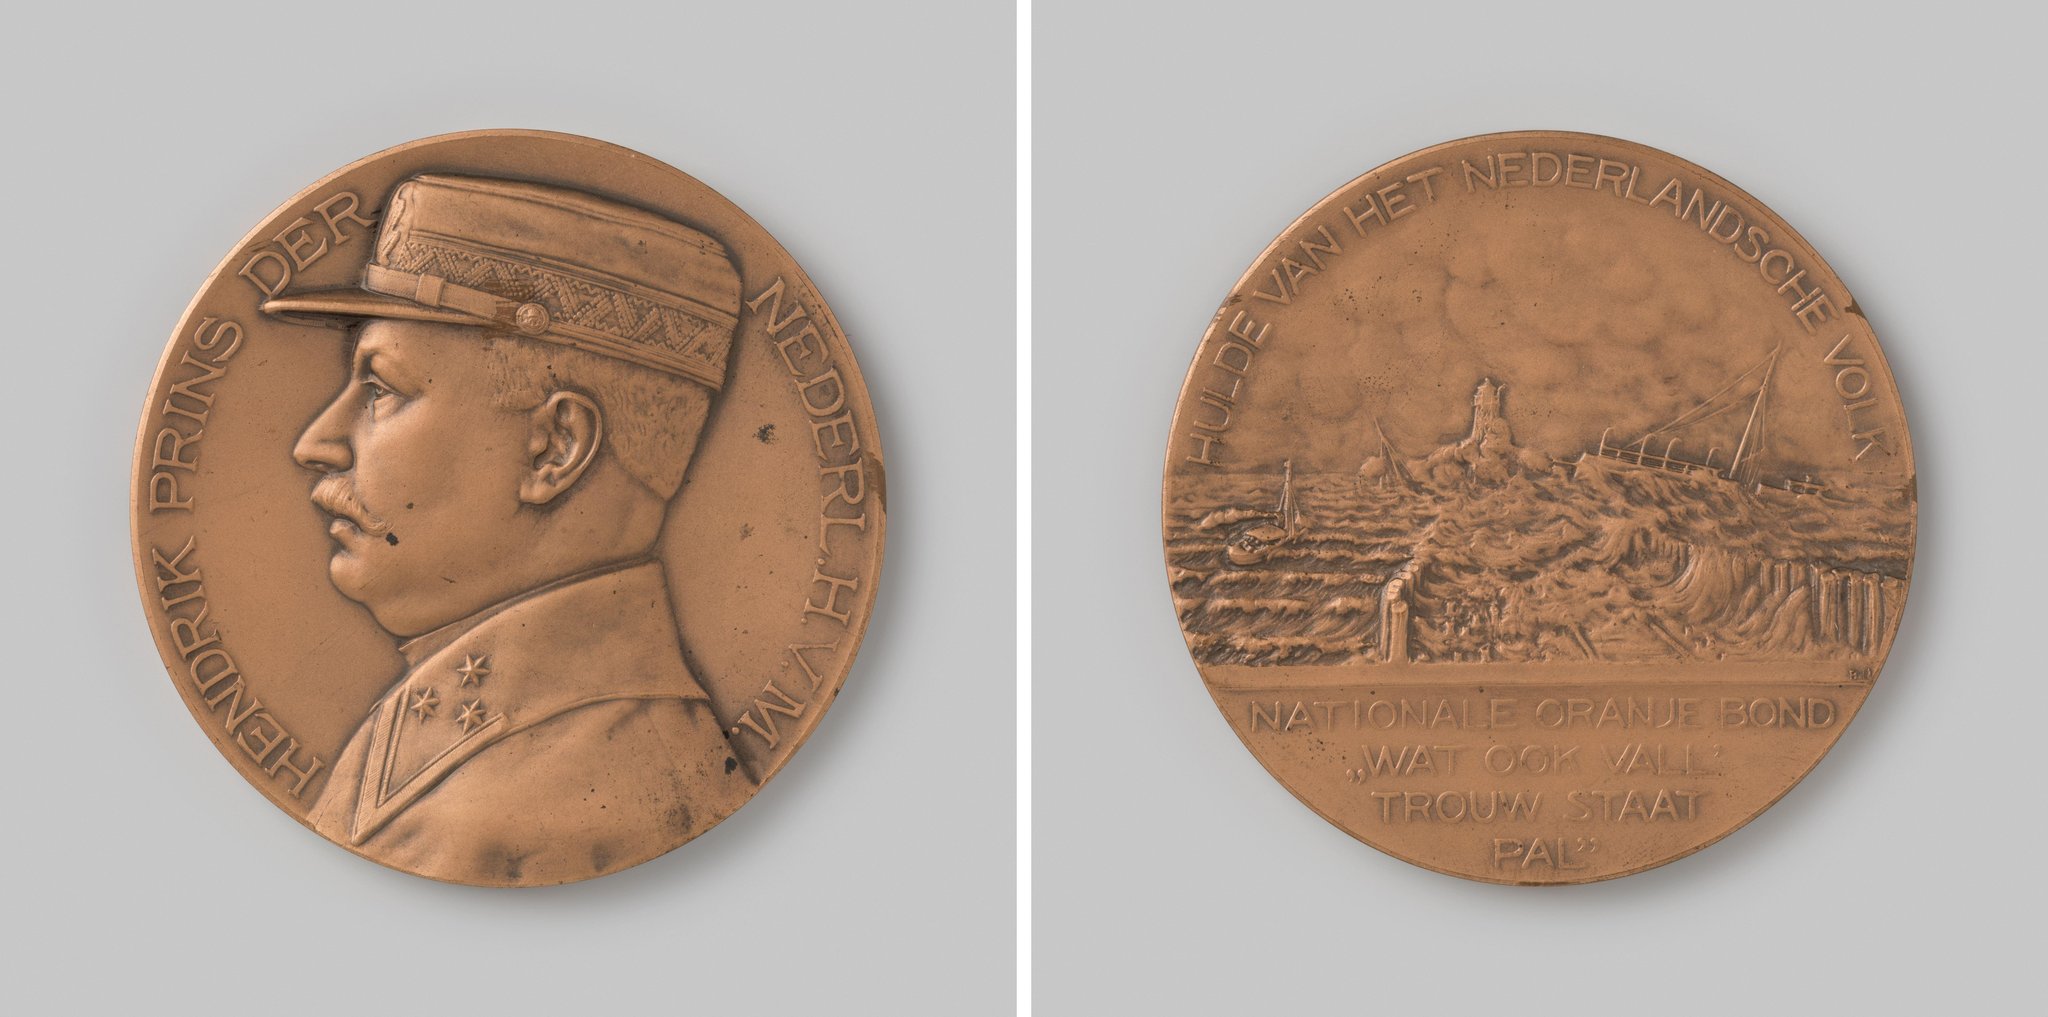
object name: history medal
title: Hulde aan Prins Hendrik der Nederlanden bij de Zeeramp bij Hoek van Holland 1907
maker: jacob jan van goor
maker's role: medailleur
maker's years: 1874-1956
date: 1907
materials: bronze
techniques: striking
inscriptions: inscription: ‘BRONS’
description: Bronzen penning, op de voorzijde het geüniformeerde borstbeeld van Prins Hendrik naar links met omschrift, op de keerzijde schepen en een vuurtoren in een kolkende zee, met omschrift en afsnedetekst.